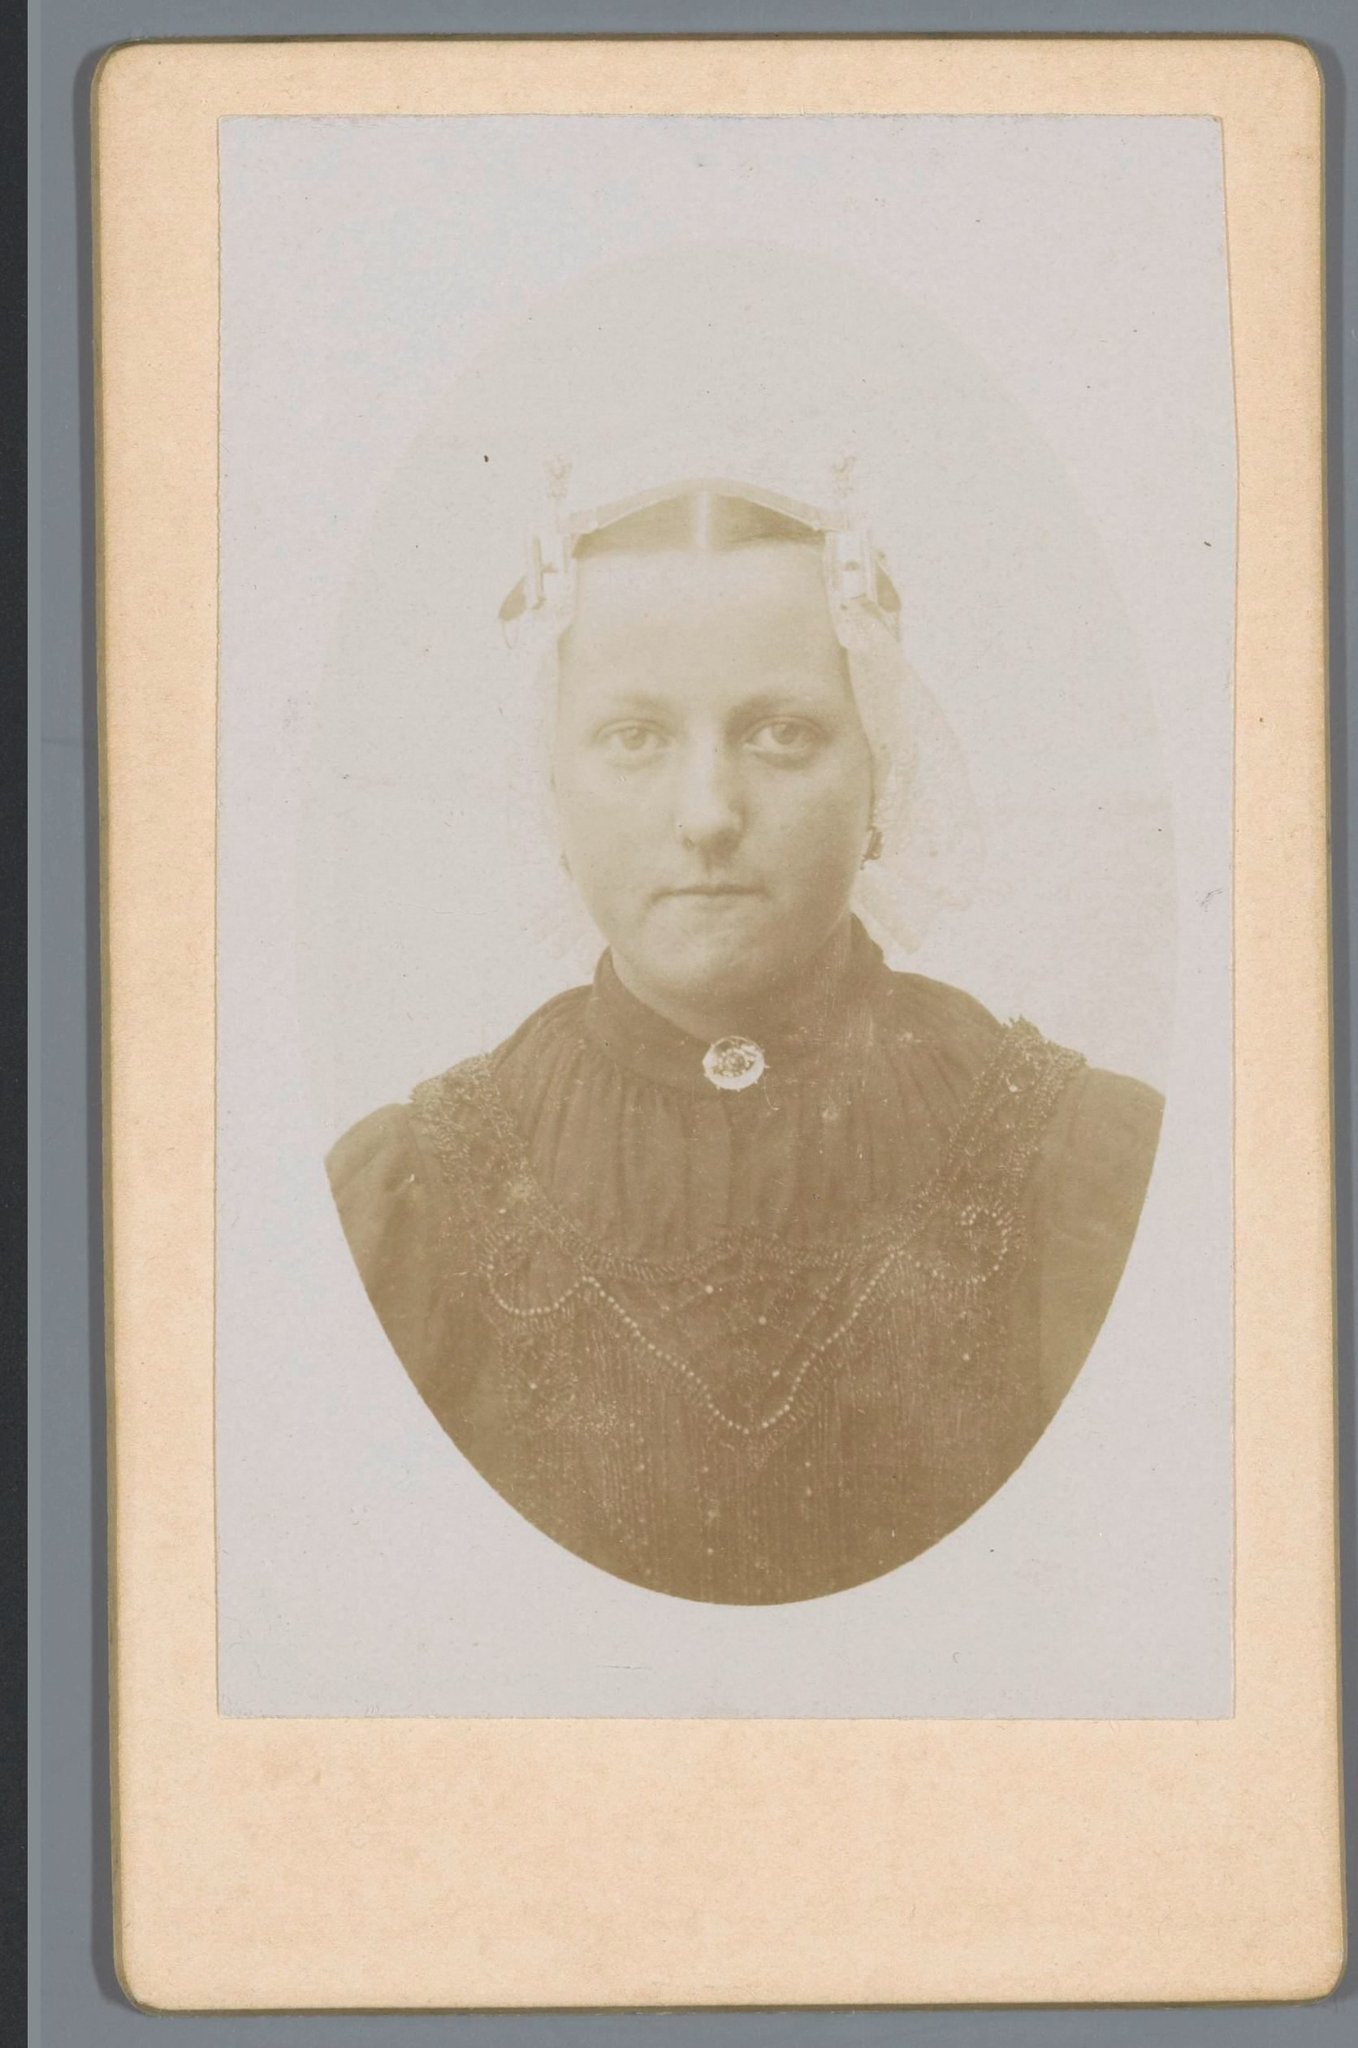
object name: carte de visite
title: Portret van een onbekende vrouw, aangeduid als M. Boon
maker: Anonymous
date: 1880-1920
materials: cardboard, photographic support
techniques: collodion silver print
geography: netherlands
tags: historical persons - bb - woman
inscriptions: inscription: ‘M. Boon’